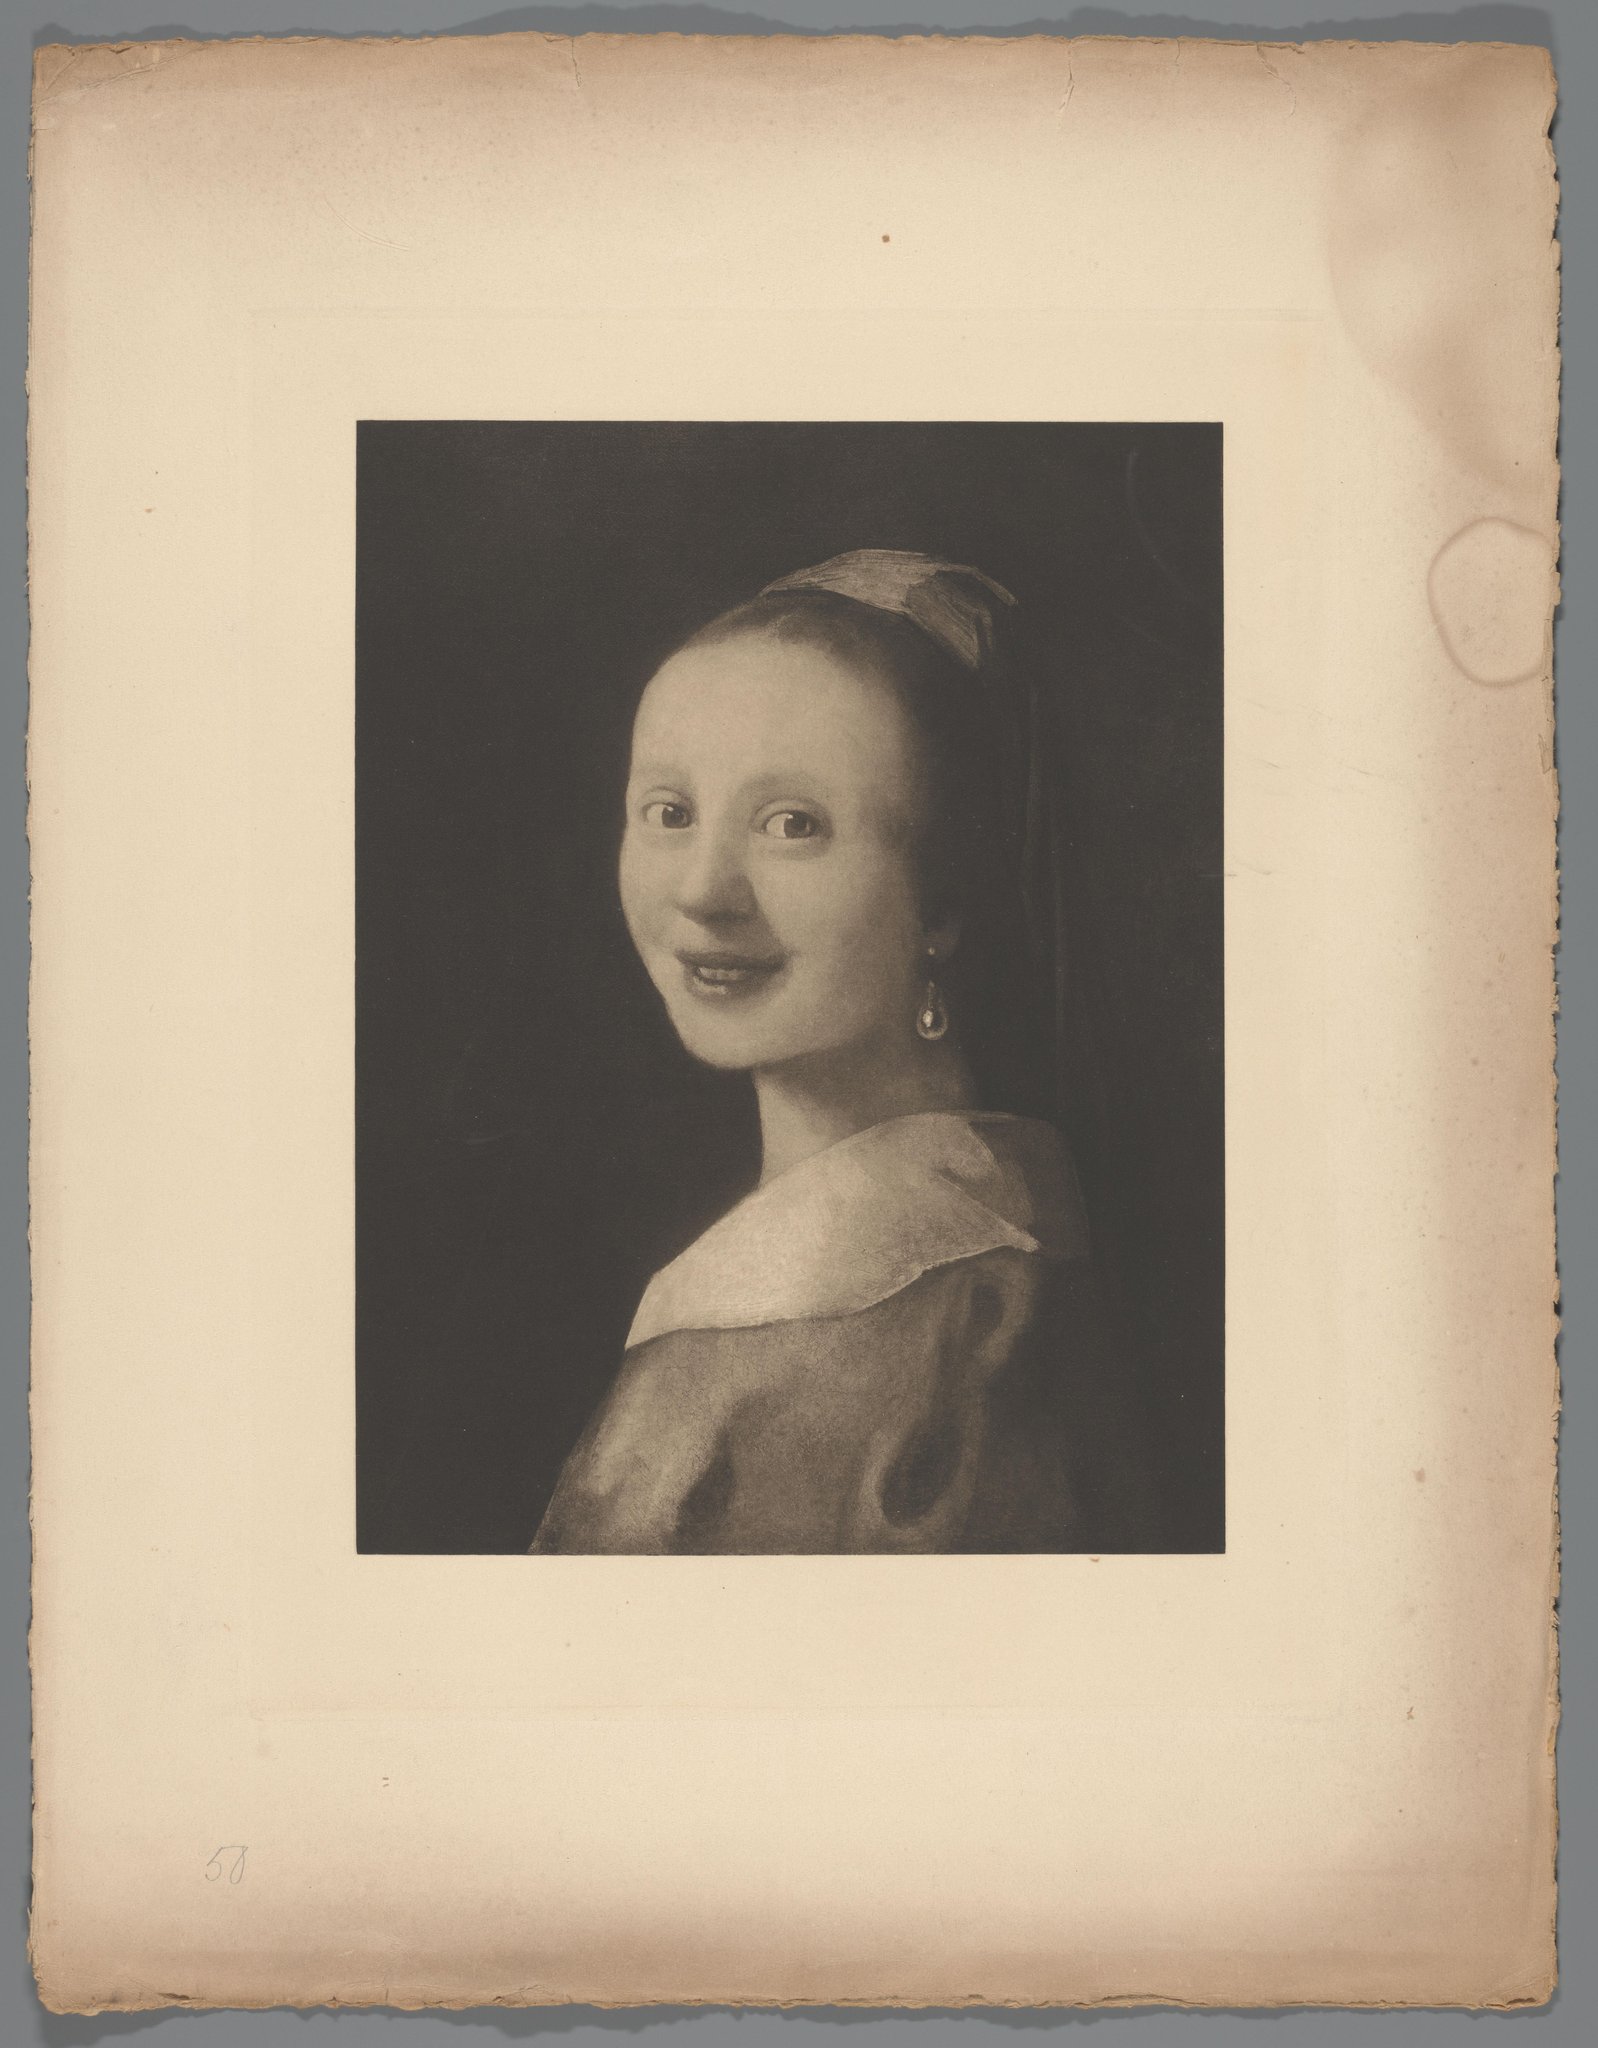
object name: reproduction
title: Reproductie van het schilderij Lachend meisje door een imitator van Johannes Vermeer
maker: Anonymous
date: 1880-2023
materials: paper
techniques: photoaquatint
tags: adolescent, young woman, maiden, anonymous historical person portrayed alone - bb - woman, smiling, pearl; pearl necklace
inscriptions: number: ‘50’